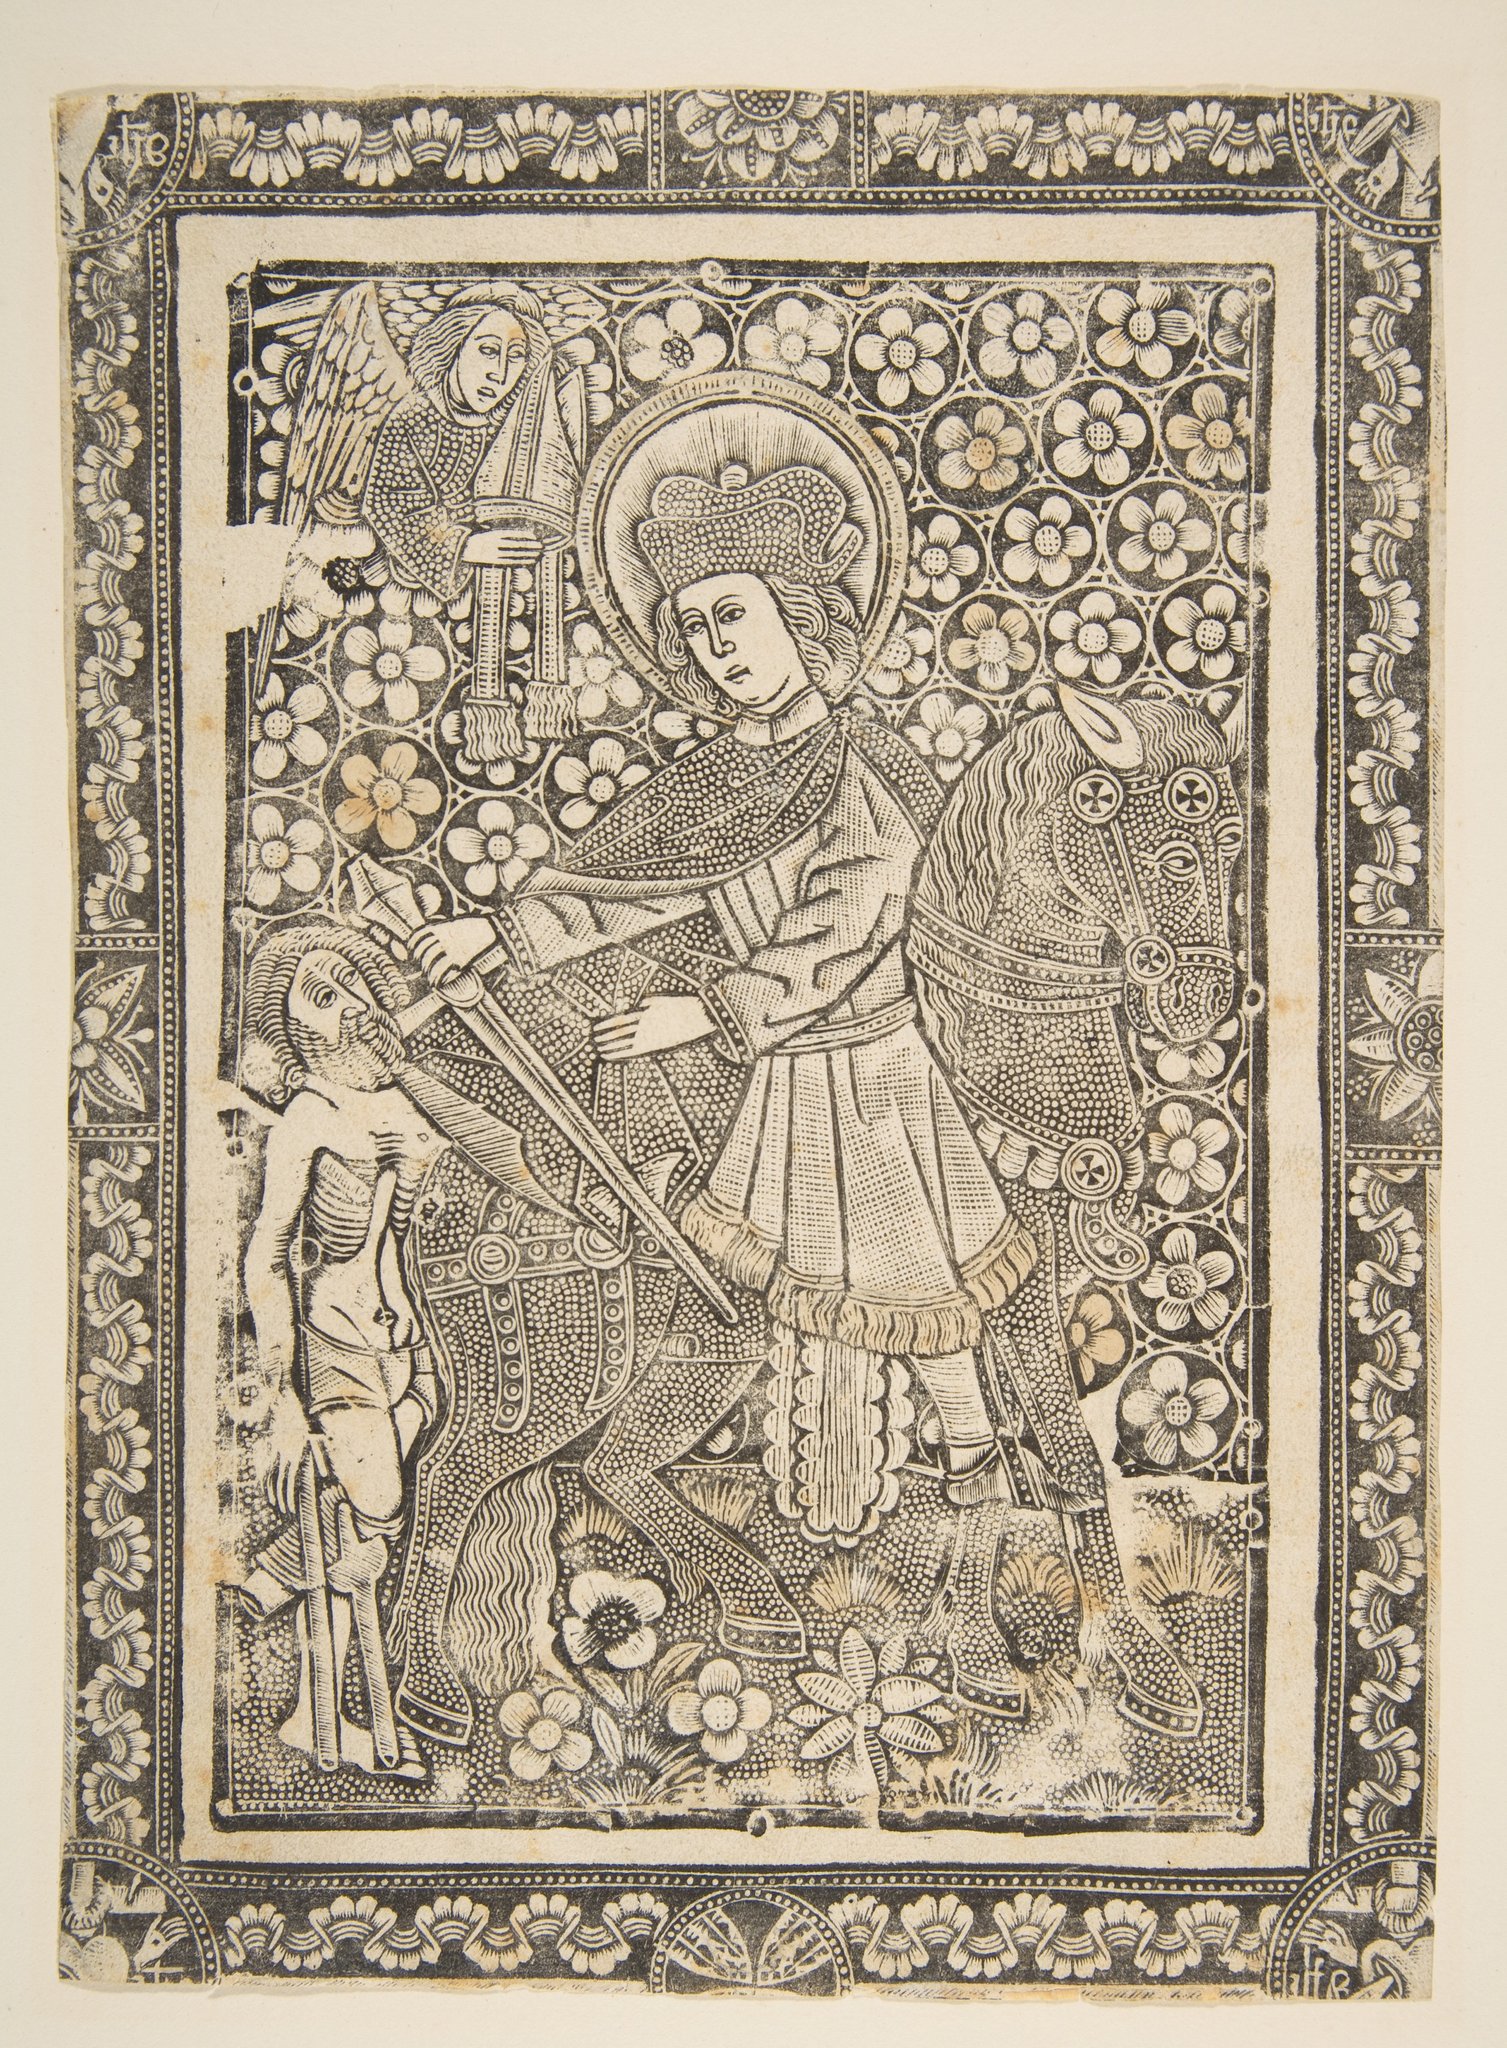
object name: print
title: St. Martin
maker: anonymous, german, 15th century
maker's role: artist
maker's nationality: german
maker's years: 1400-1500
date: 1401-1500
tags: swords,men,horses,angels,saints